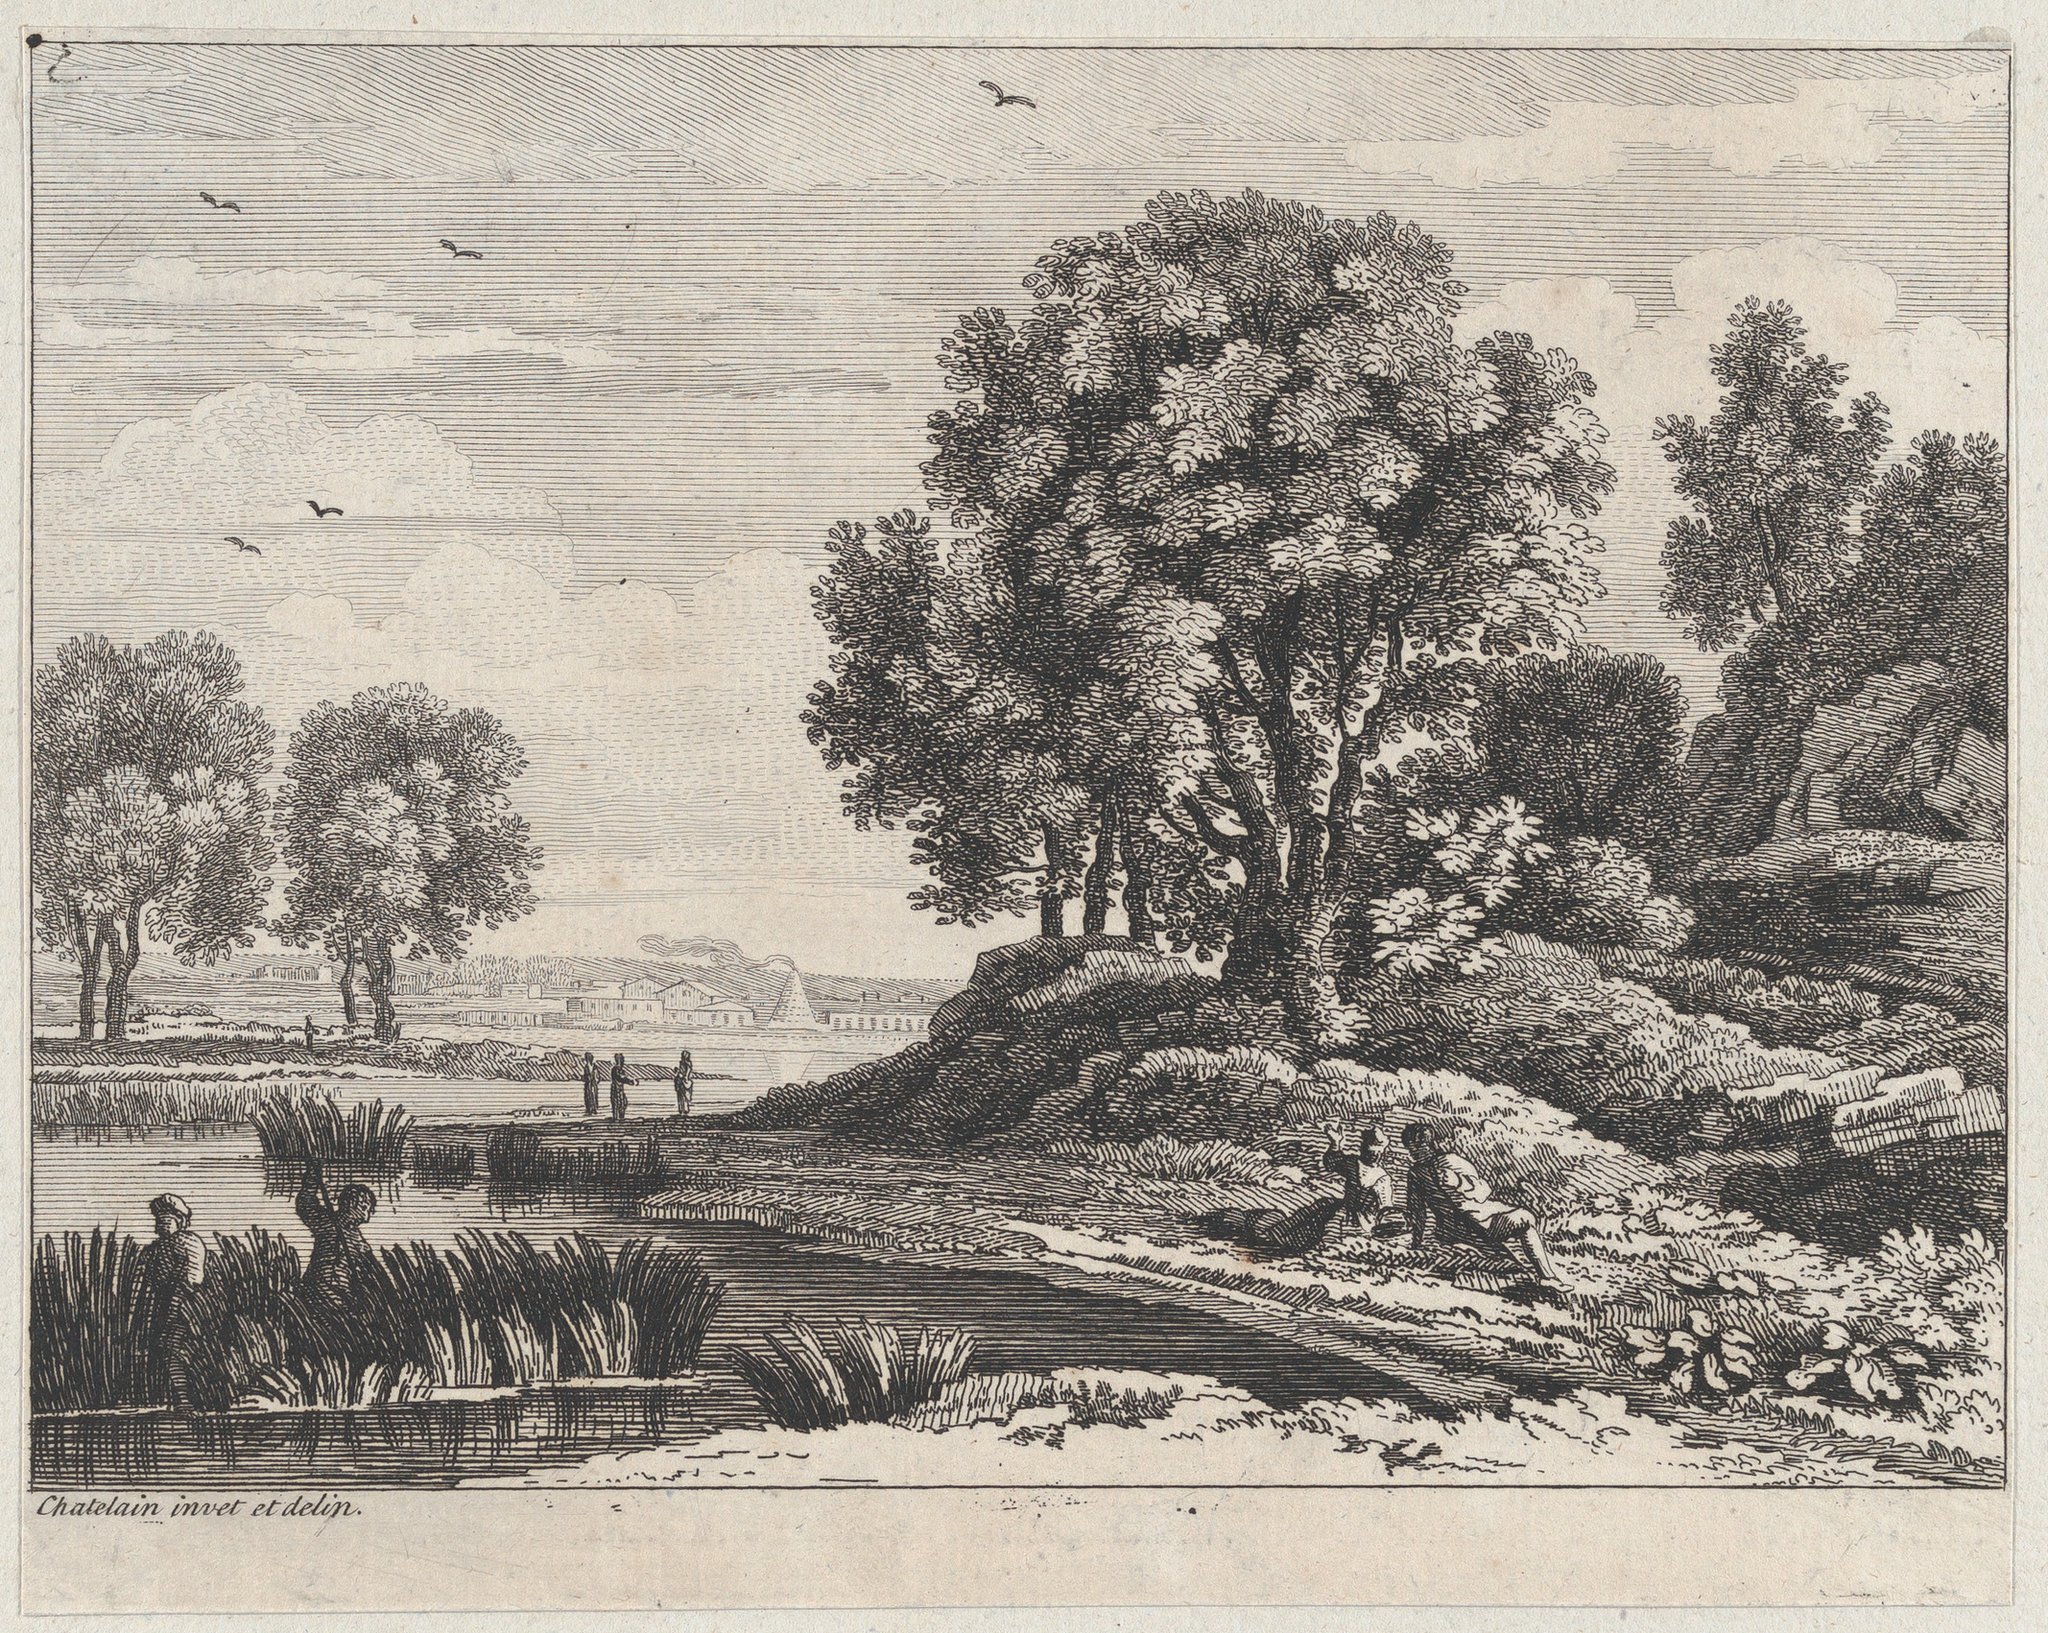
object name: print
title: Landscape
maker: jean-baptiste-claude chatelain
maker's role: artist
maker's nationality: british, french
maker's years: 1705-1758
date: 1730-1758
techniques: etching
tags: landscapes,trees